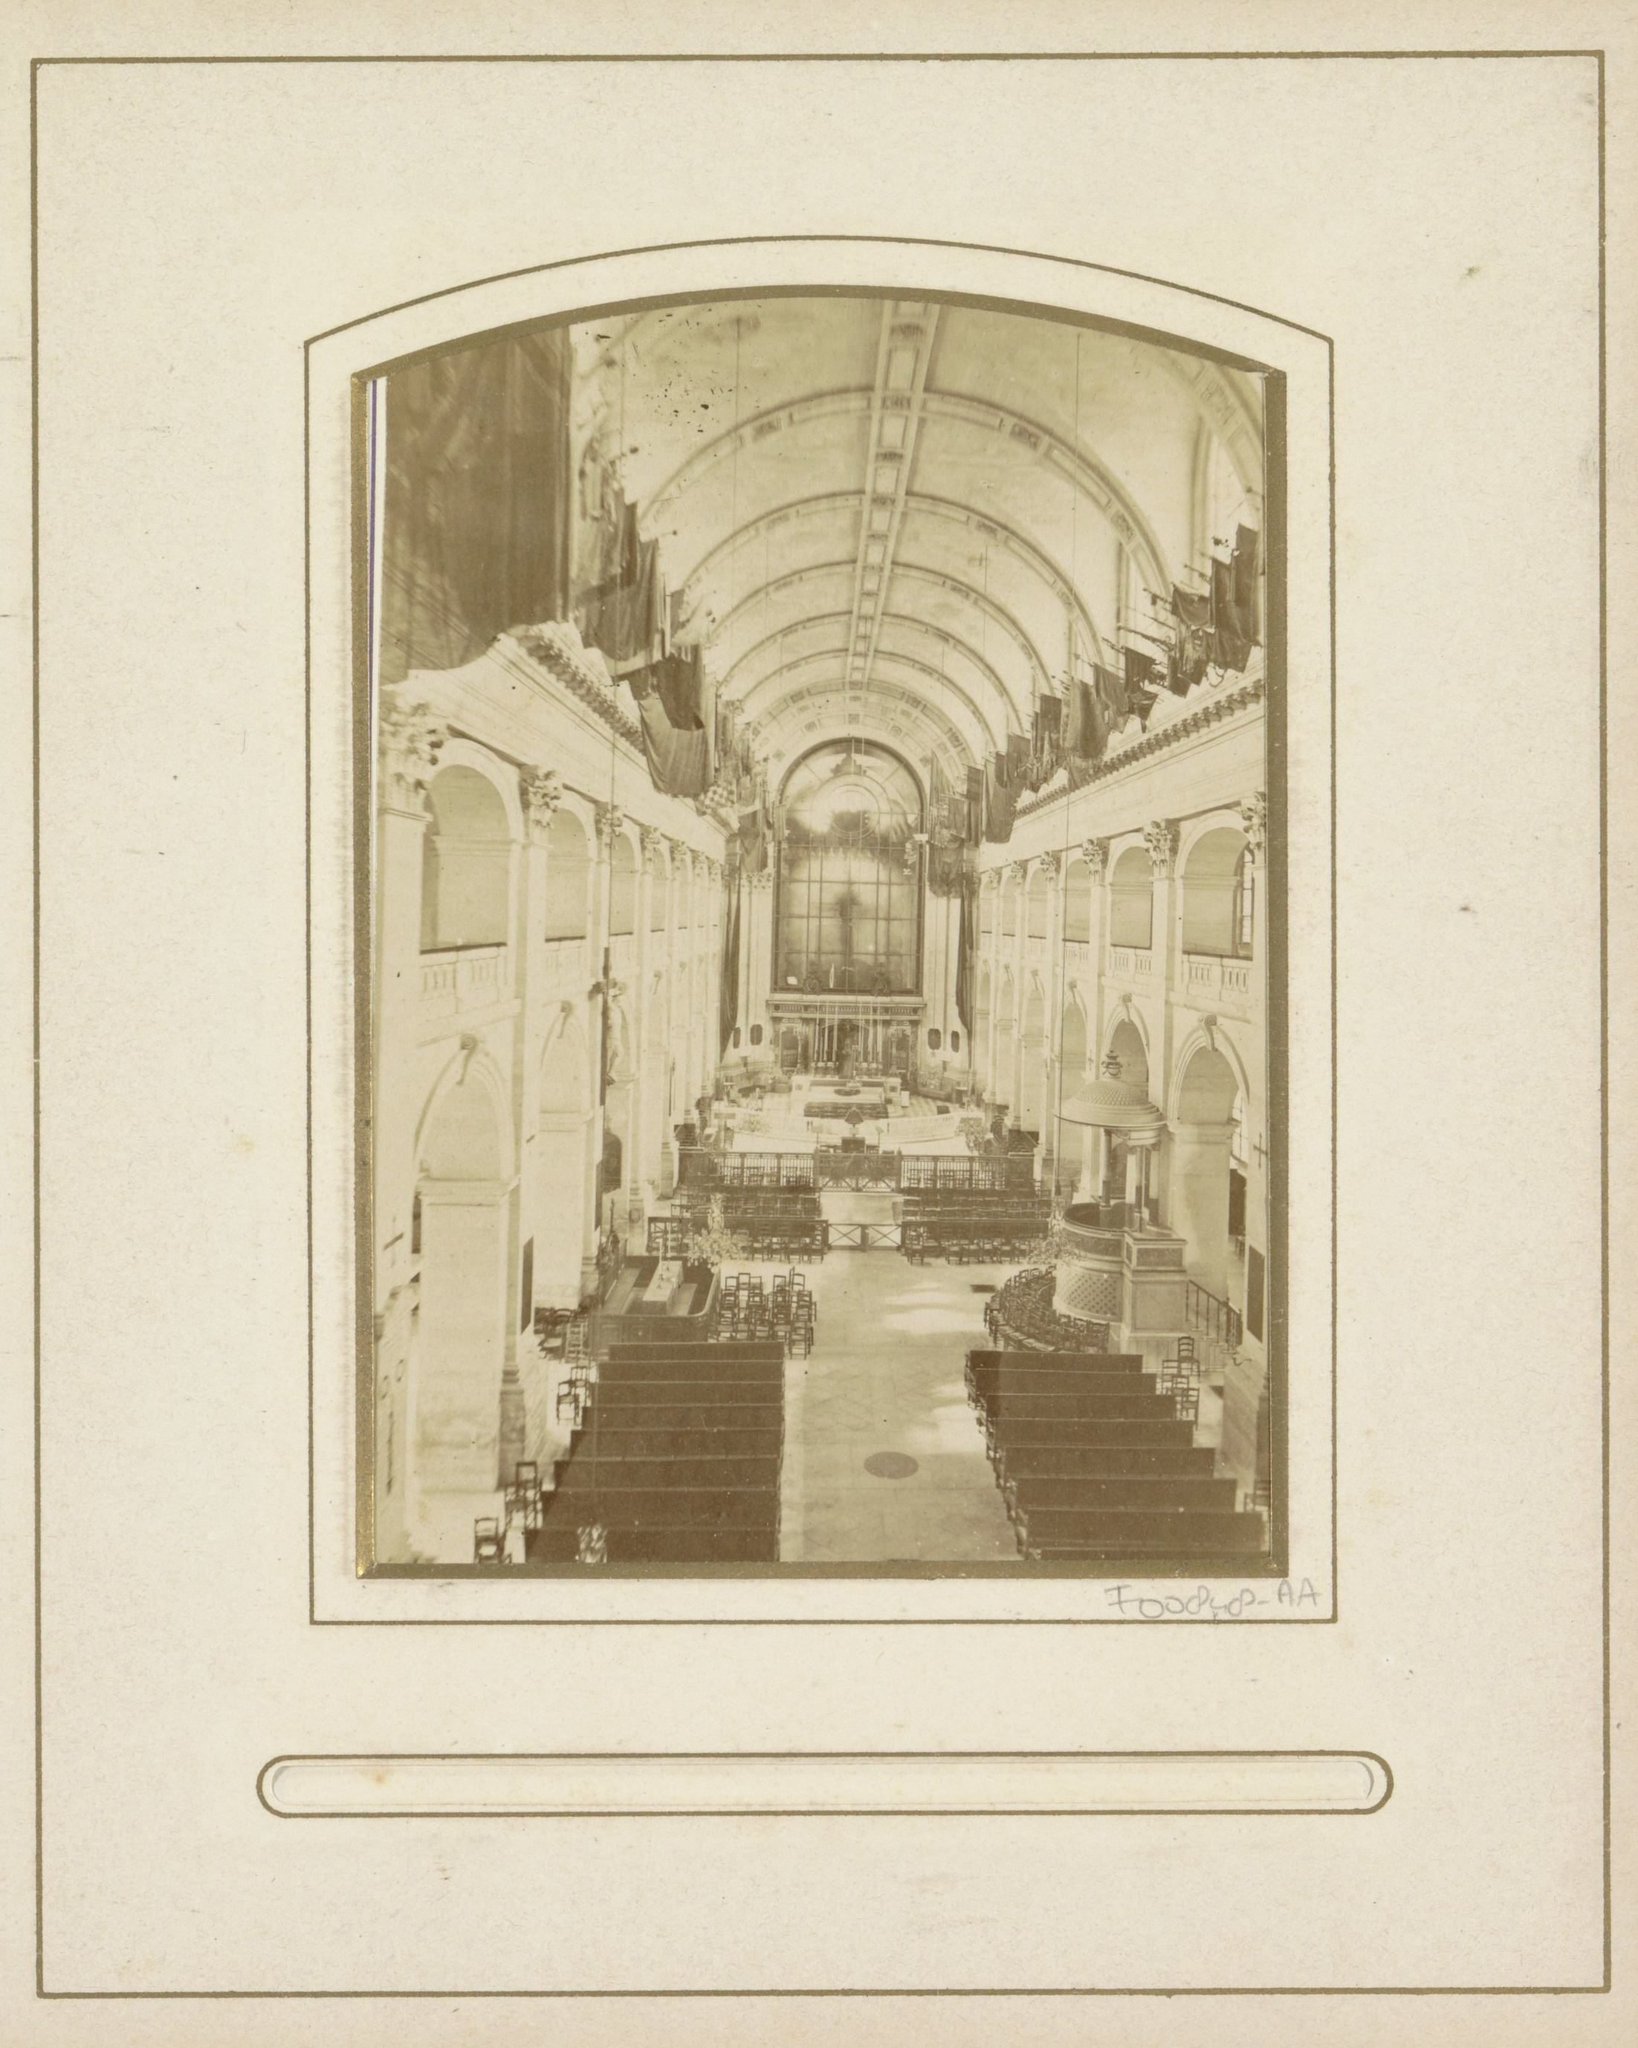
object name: cabinet photograph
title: Interieur van de Cathédrale Saint-Louis des Invalides in Parijs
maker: Anonymous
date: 1870-1900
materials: cardboard, paper, photographic support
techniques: albumen print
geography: paris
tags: parts of church interior: nave, parts of church interior: choir, (military) flags and standards, paris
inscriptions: inscription: ‘interieur du Pantheon’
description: Op de achterzijde van deze kabinetfoto staat vermeld dat het "interieur du Pantheon" afgebeeld is. Dit is onjuist.